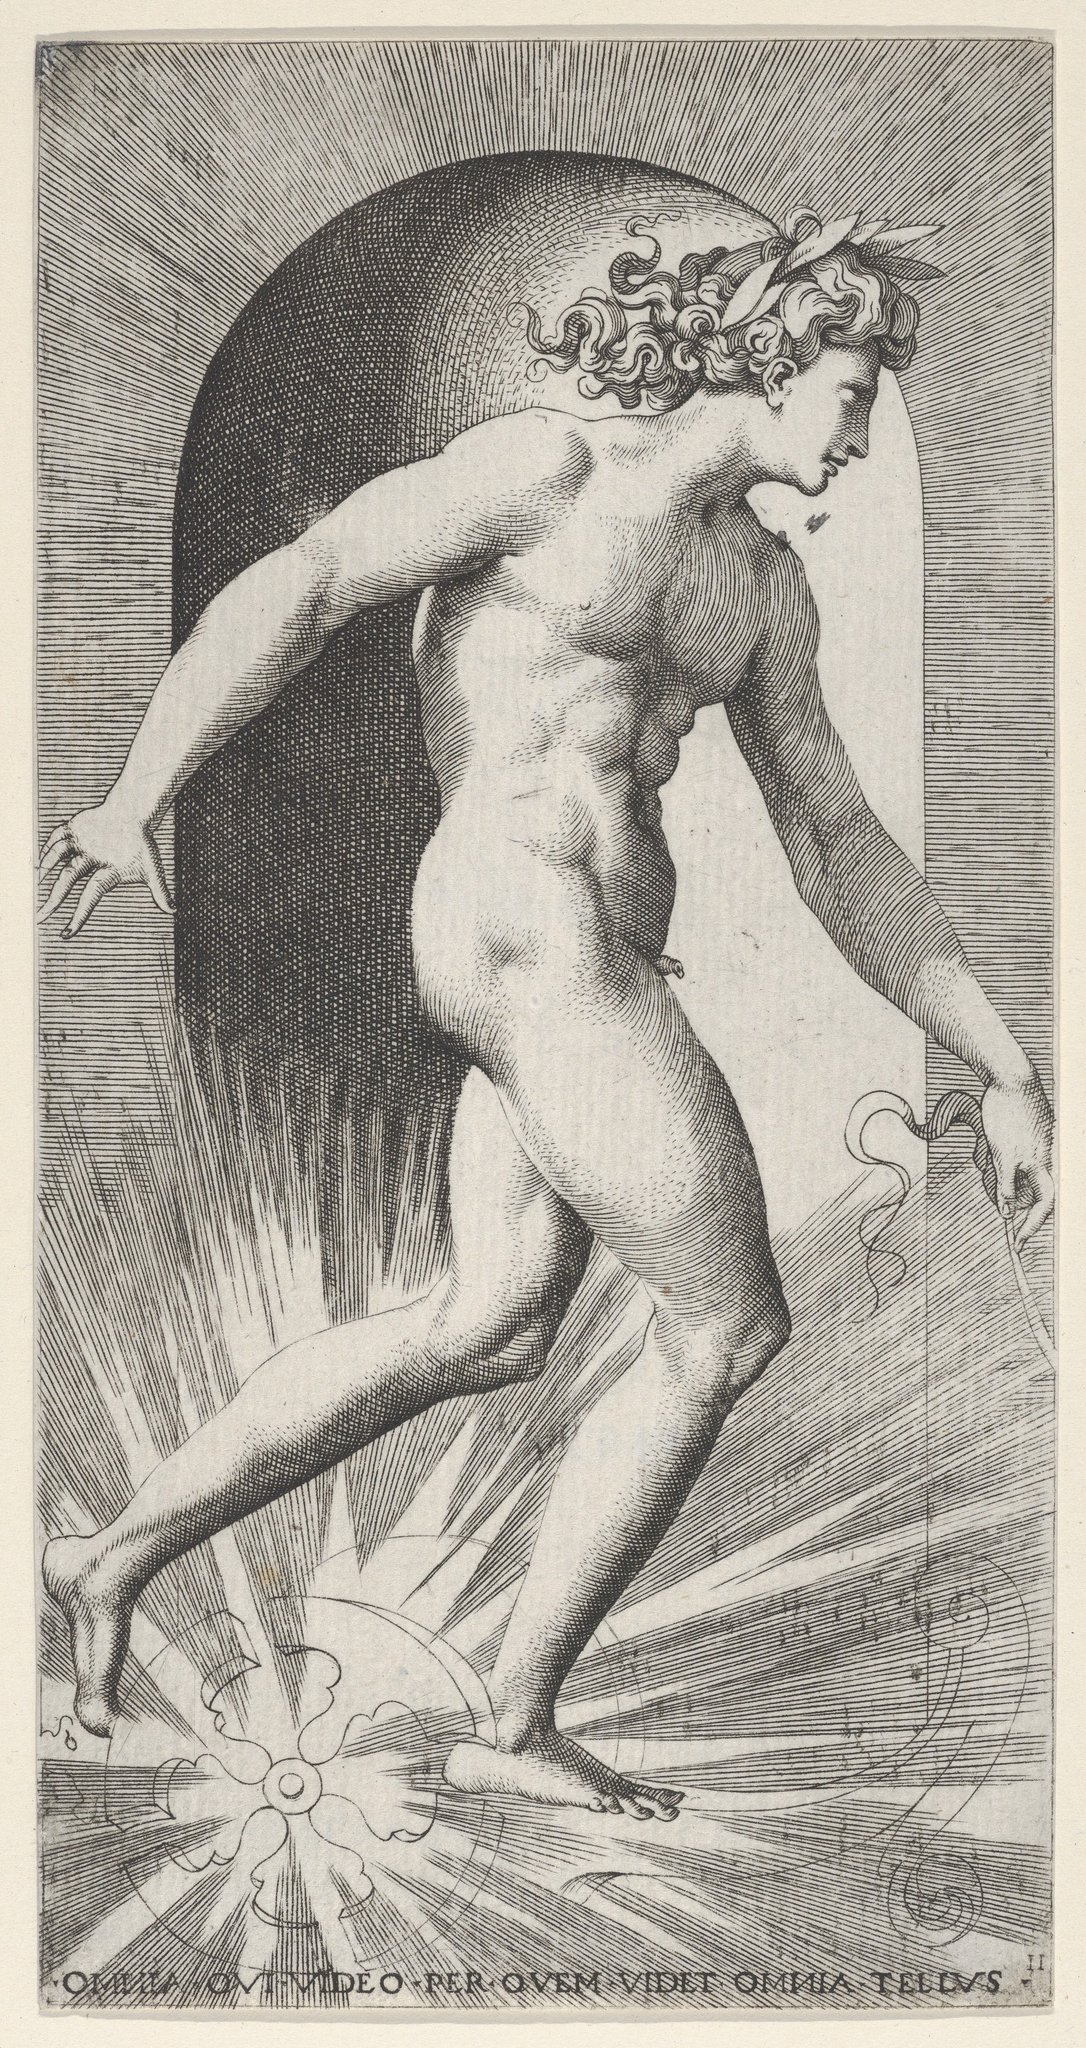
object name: print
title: Plate 11: Apollo riding his chariot in a niche, facing right, from "Mythological Gods and Goddesses"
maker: giovanni jacopo caraglio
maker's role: artist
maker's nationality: italian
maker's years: 1500-1565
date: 1526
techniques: engraving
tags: male nudes,apollo